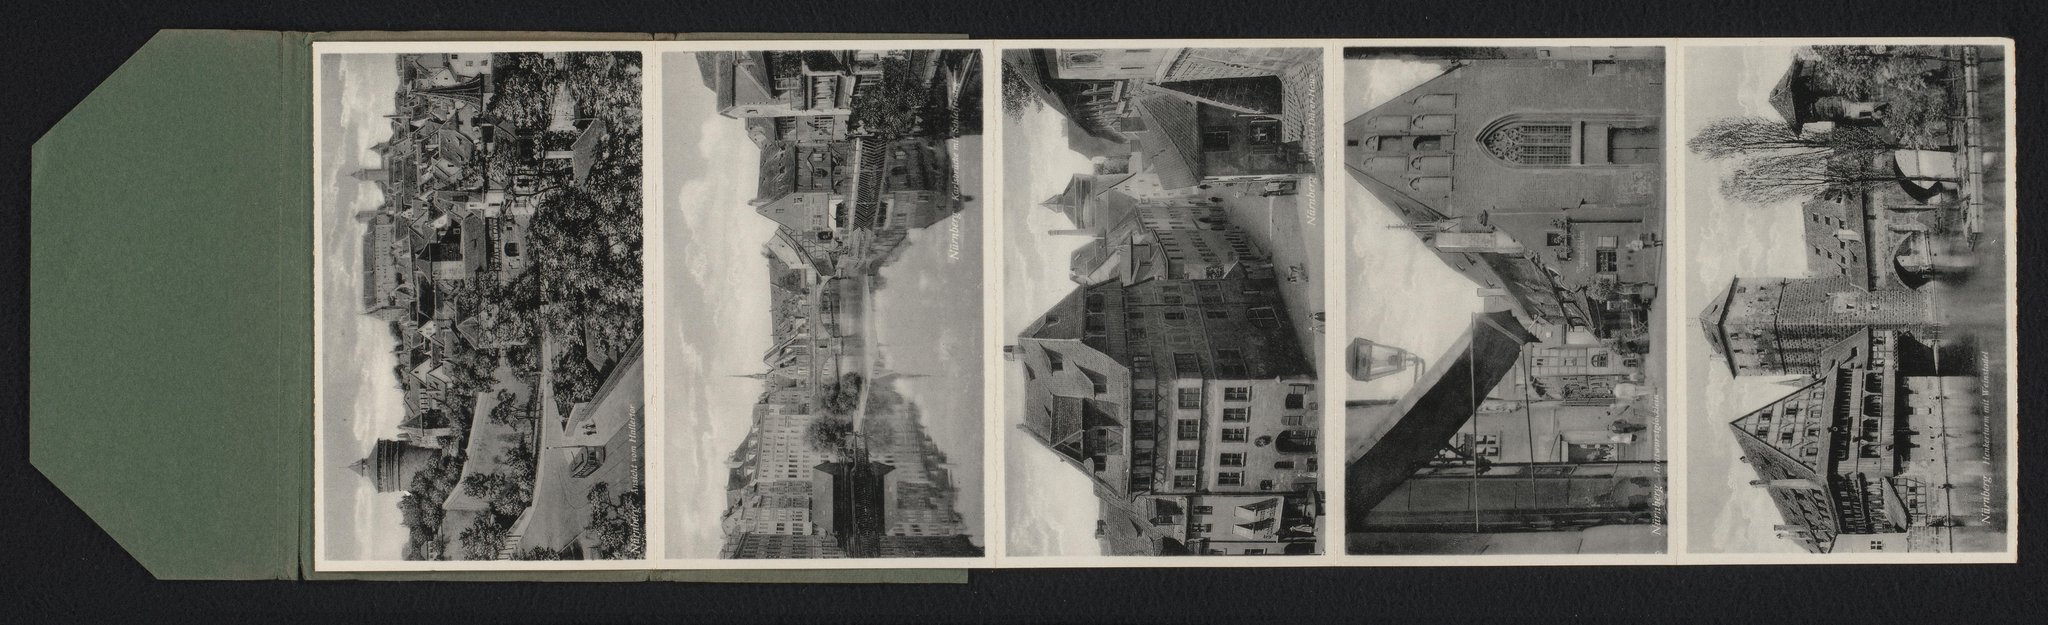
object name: accordion book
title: Leporelloalbum met stadsgezichten uit Neurenberg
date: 1905-1944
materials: cardboard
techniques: photograph, printing block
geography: darmstadt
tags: city-view, and landscape with man-made constructions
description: Het leporelloalbum is bedoeld voor twaalf prentbriefkaarten. In dit exemplaar zijn vijf prentbriefkaarten aangetroffen.